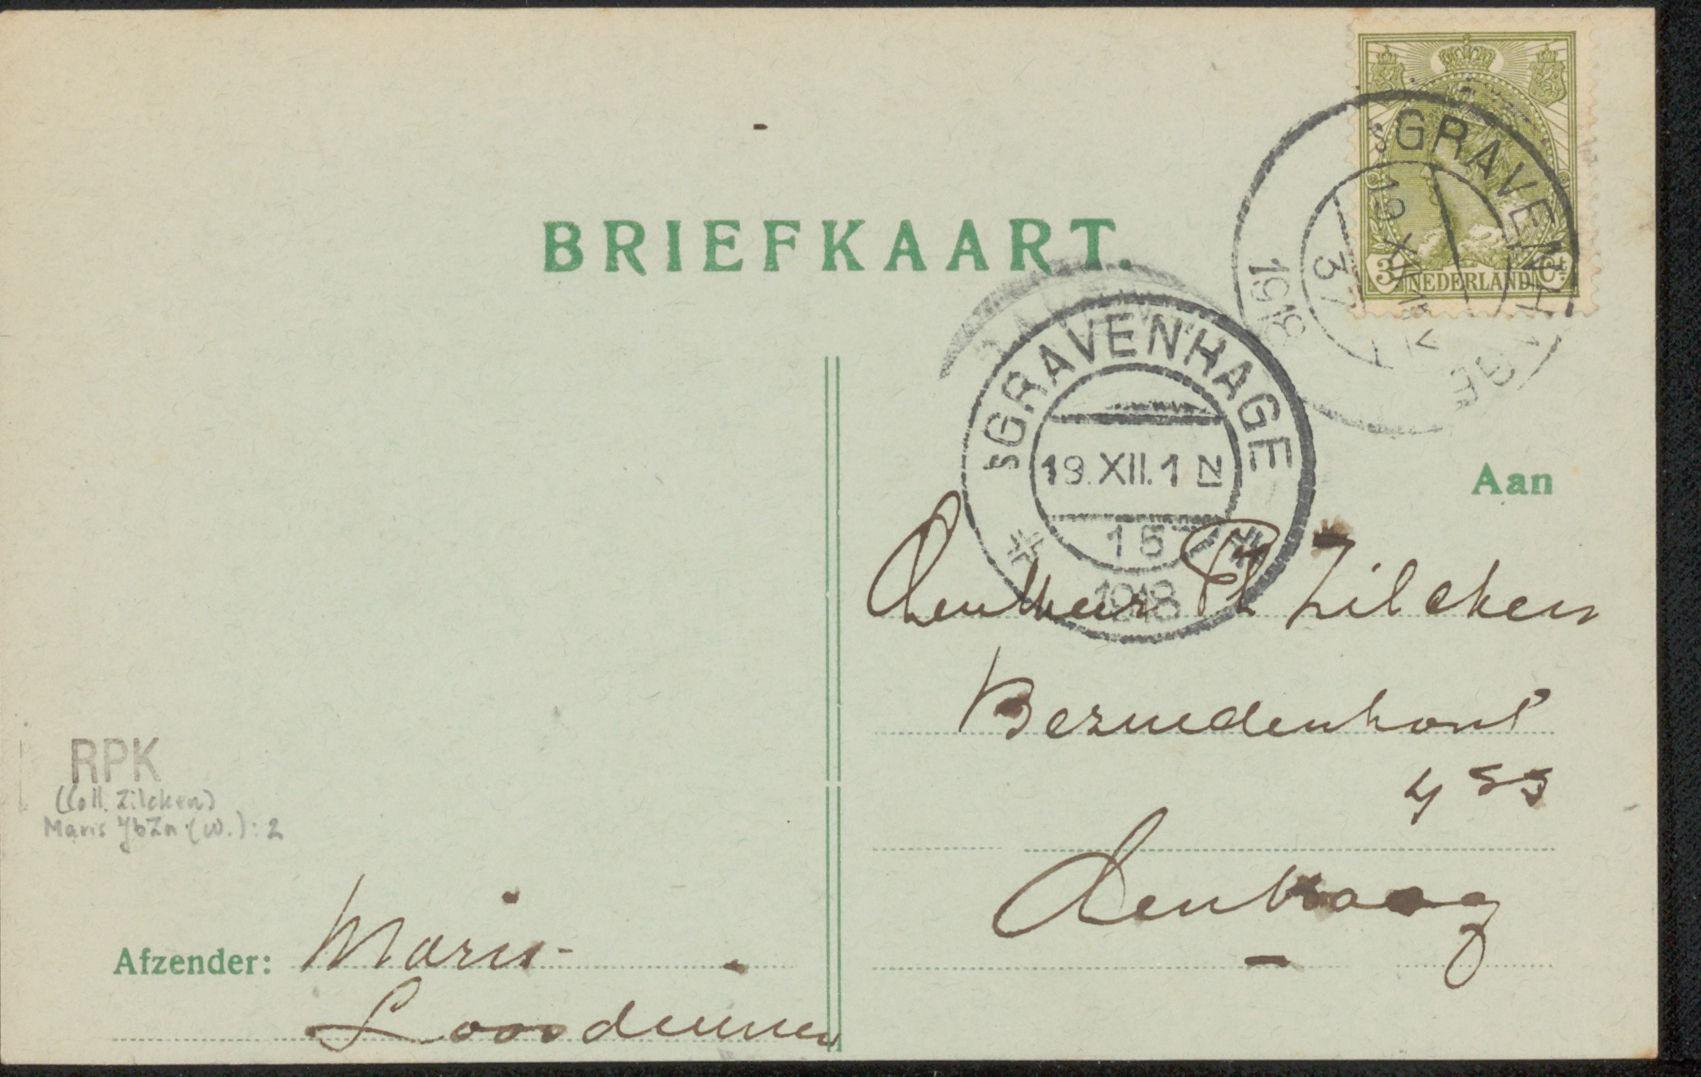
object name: postcard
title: Briefkaart aan Philip Zilcken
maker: willem matthijs maris jbzn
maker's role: print maker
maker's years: 1872-1929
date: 1918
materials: cardboard, ink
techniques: pen, writing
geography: the hague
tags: the hague, painter, draughtsman, philip zilcken, exhibition ~ art, venice, amsterdam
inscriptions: collector's mark: ‘RPK’